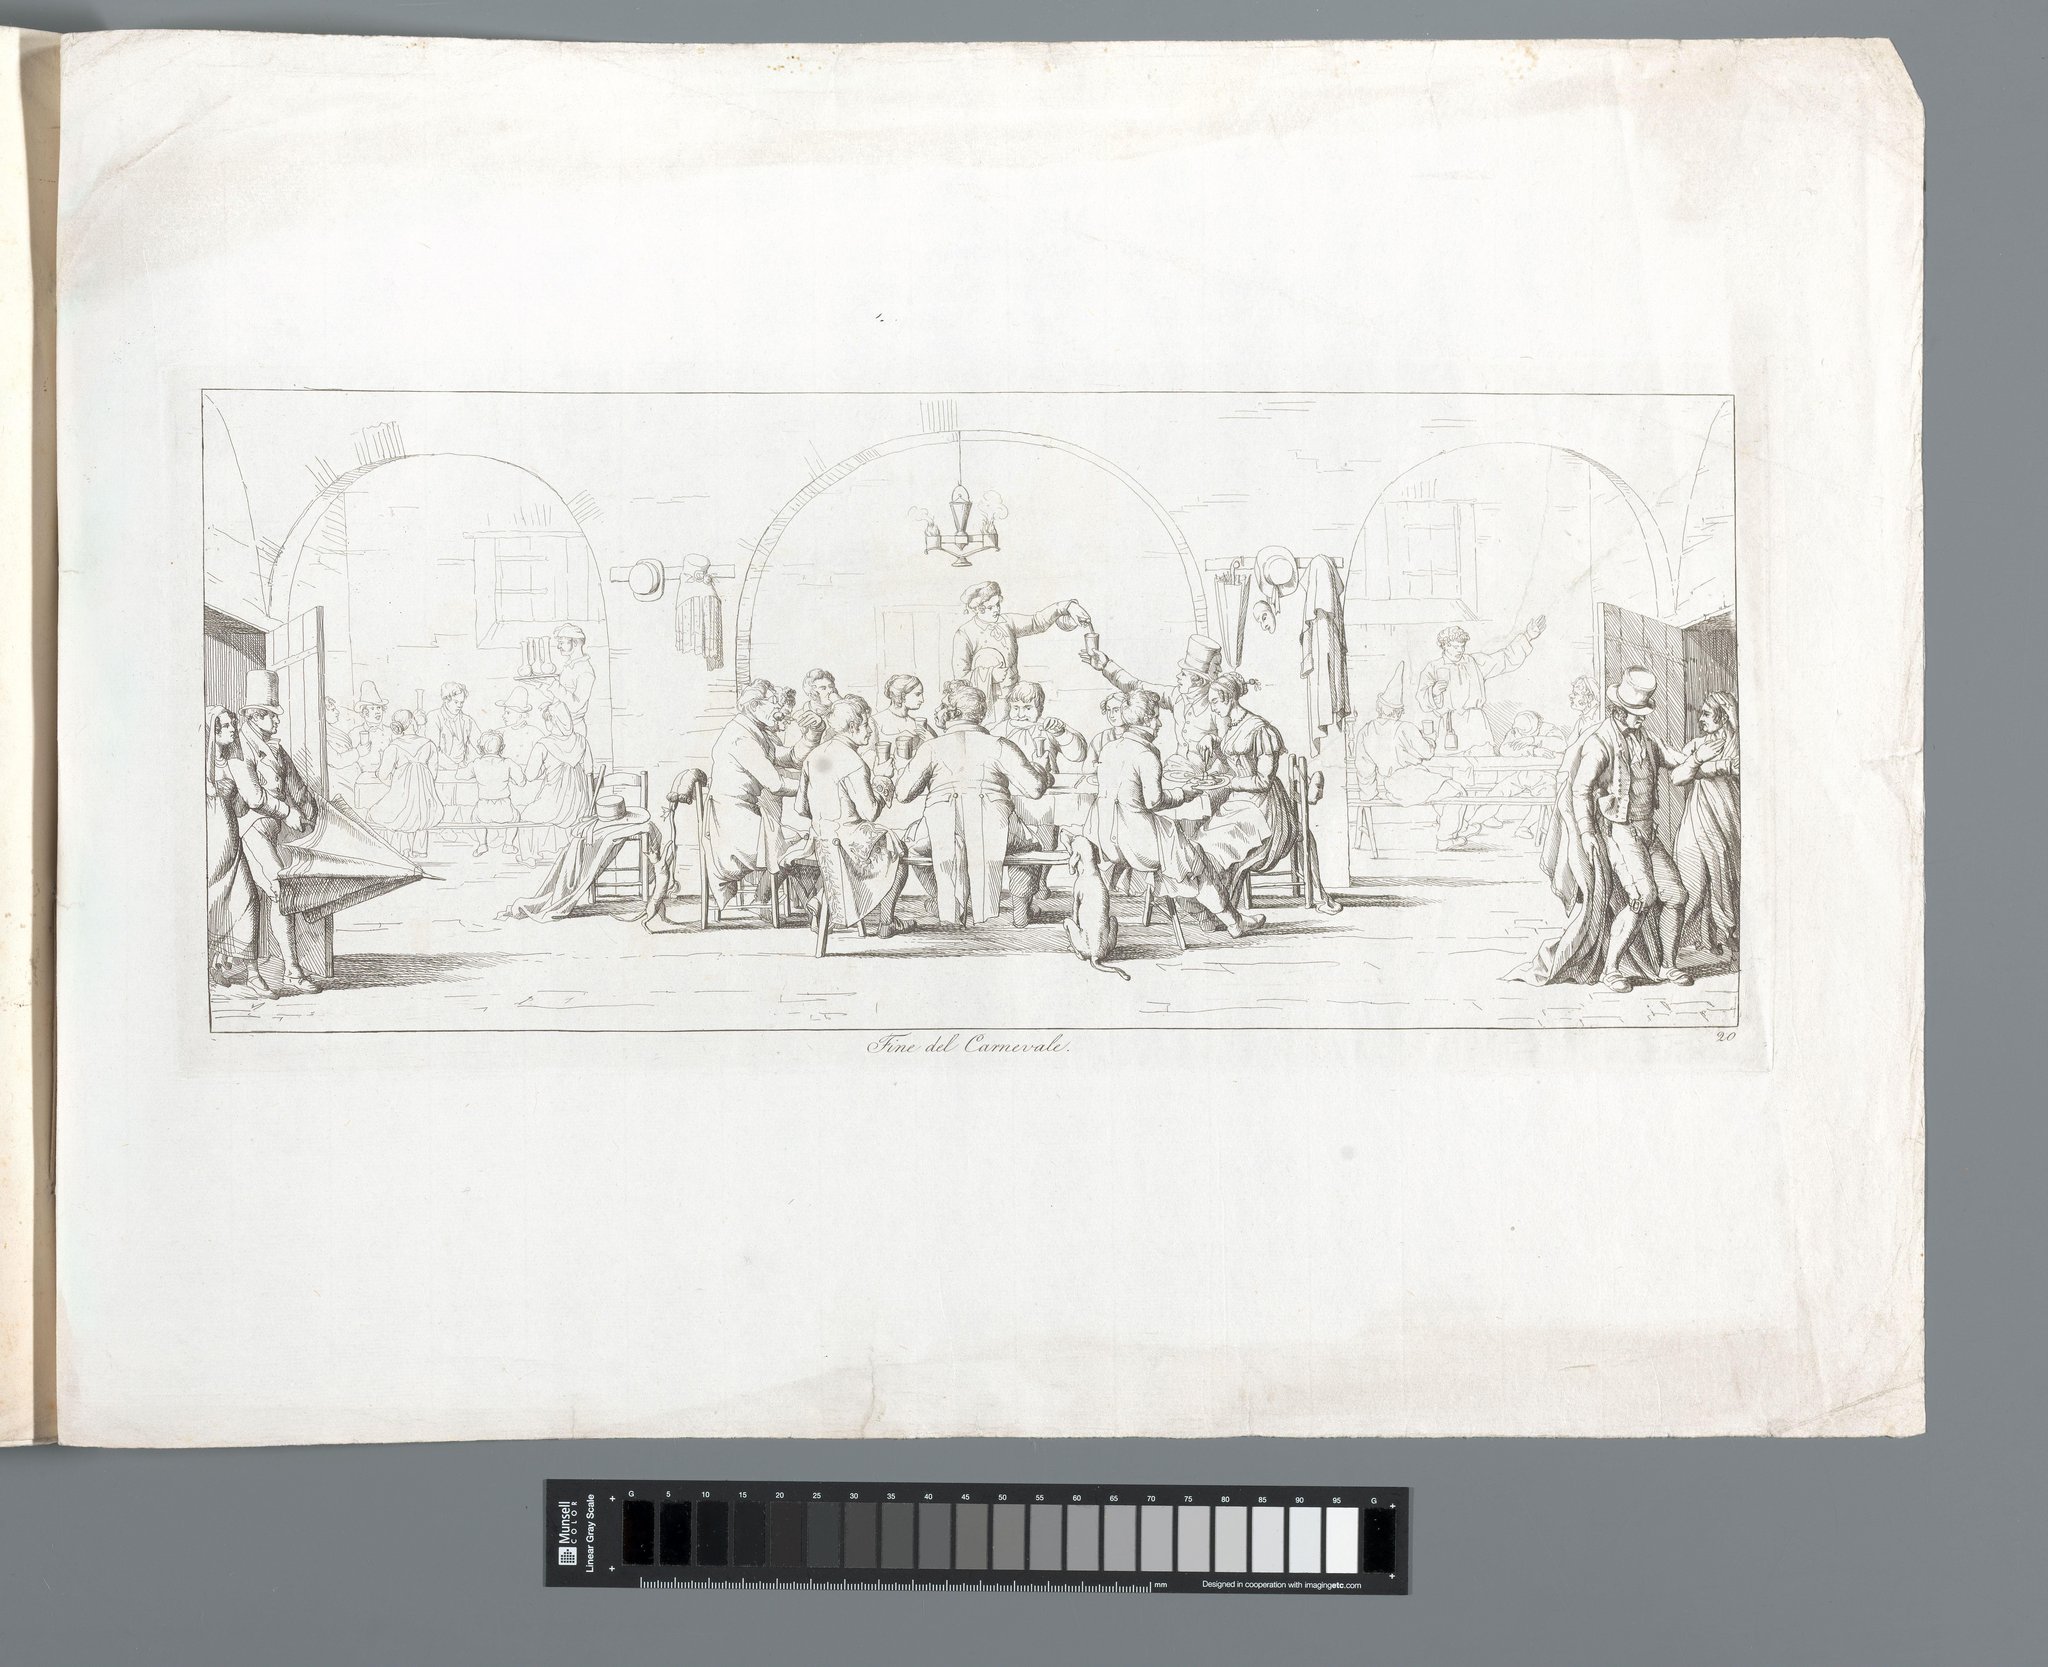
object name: print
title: Fine del Carnevale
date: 1820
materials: paper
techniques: etching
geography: rome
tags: carnival, shrovetide (non-liturgical celebration), restaurant, hotel, hostelry, inn, rome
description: Einde van het canaval. Interieur van een herberg of restaurant met verschillende groepen die aan tafels eten en drinken. Onderdeel van een prentwerk met een serie van twintig prenten over de viering van carnaval in Rome.